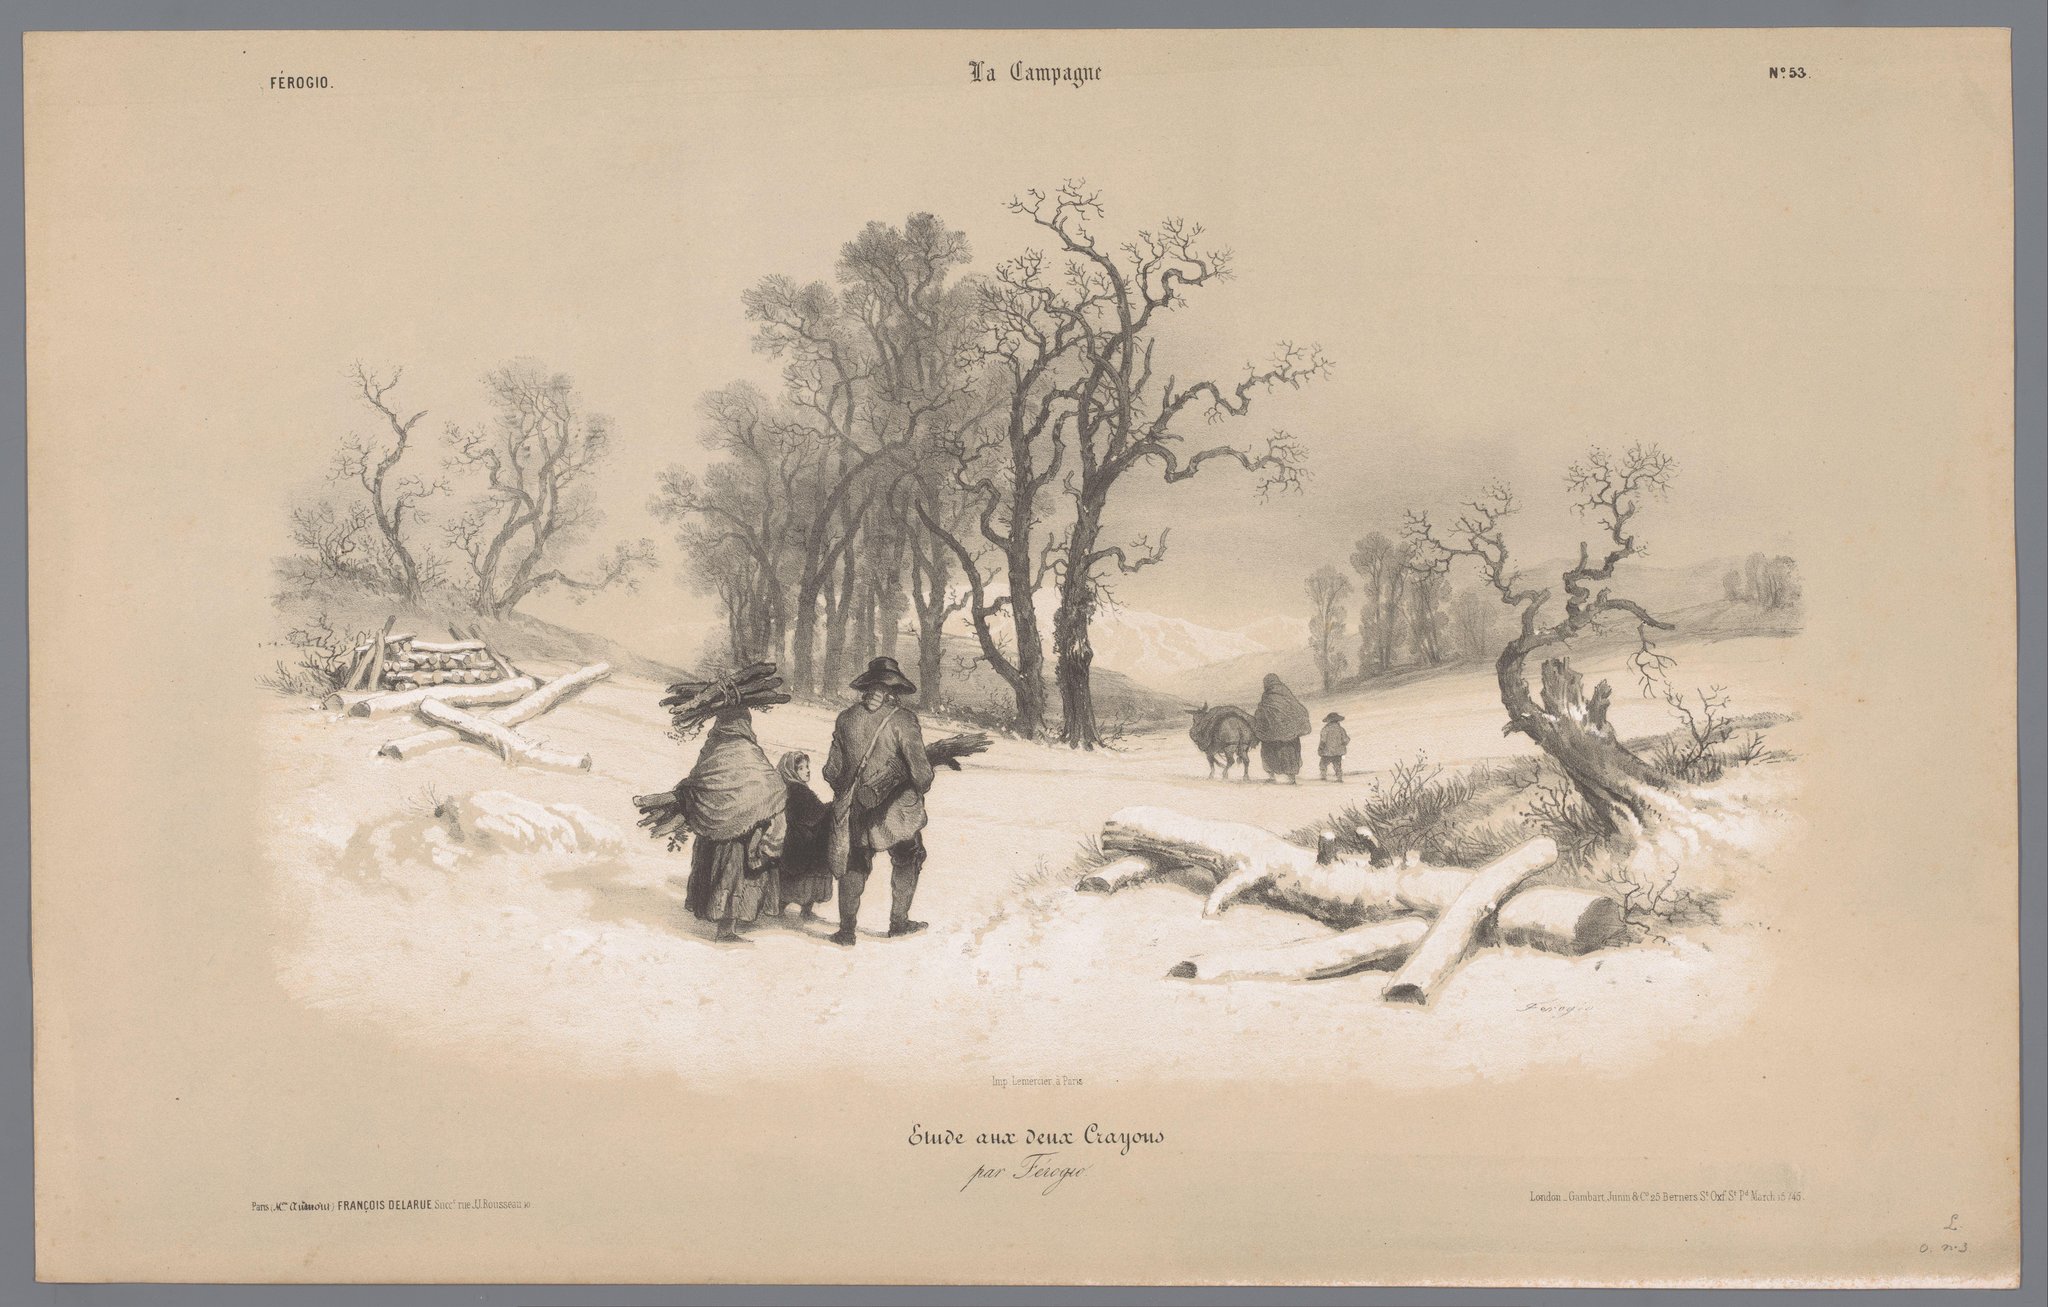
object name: print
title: Gezin sprokkelt hout in de sneeuw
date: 1844-1854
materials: paper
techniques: tone lithography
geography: paris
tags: woodgathering, woodgatherer, snow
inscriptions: collector's mark: Lugt 2228a